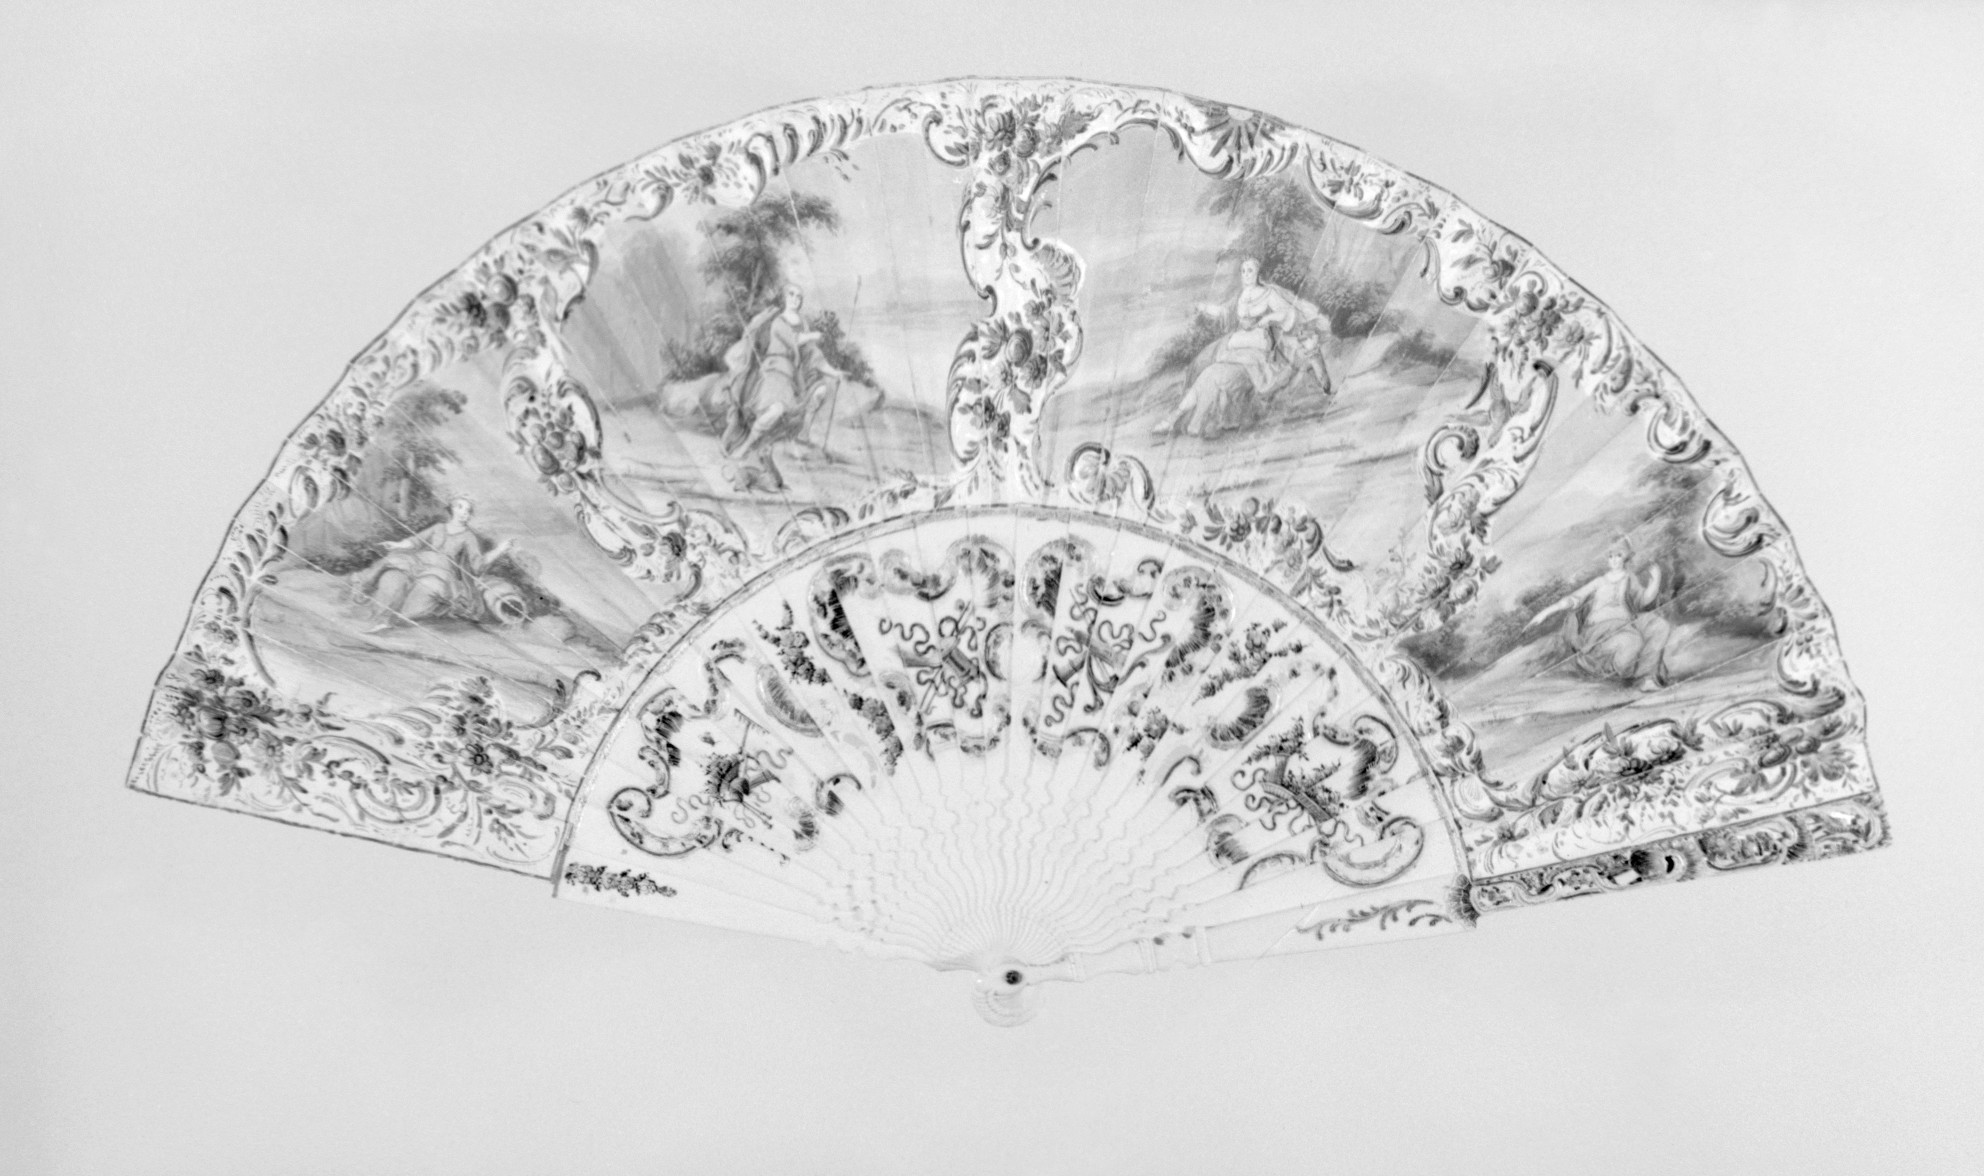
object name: fan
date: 1701-1800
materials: ivory, paper, parchment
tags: women